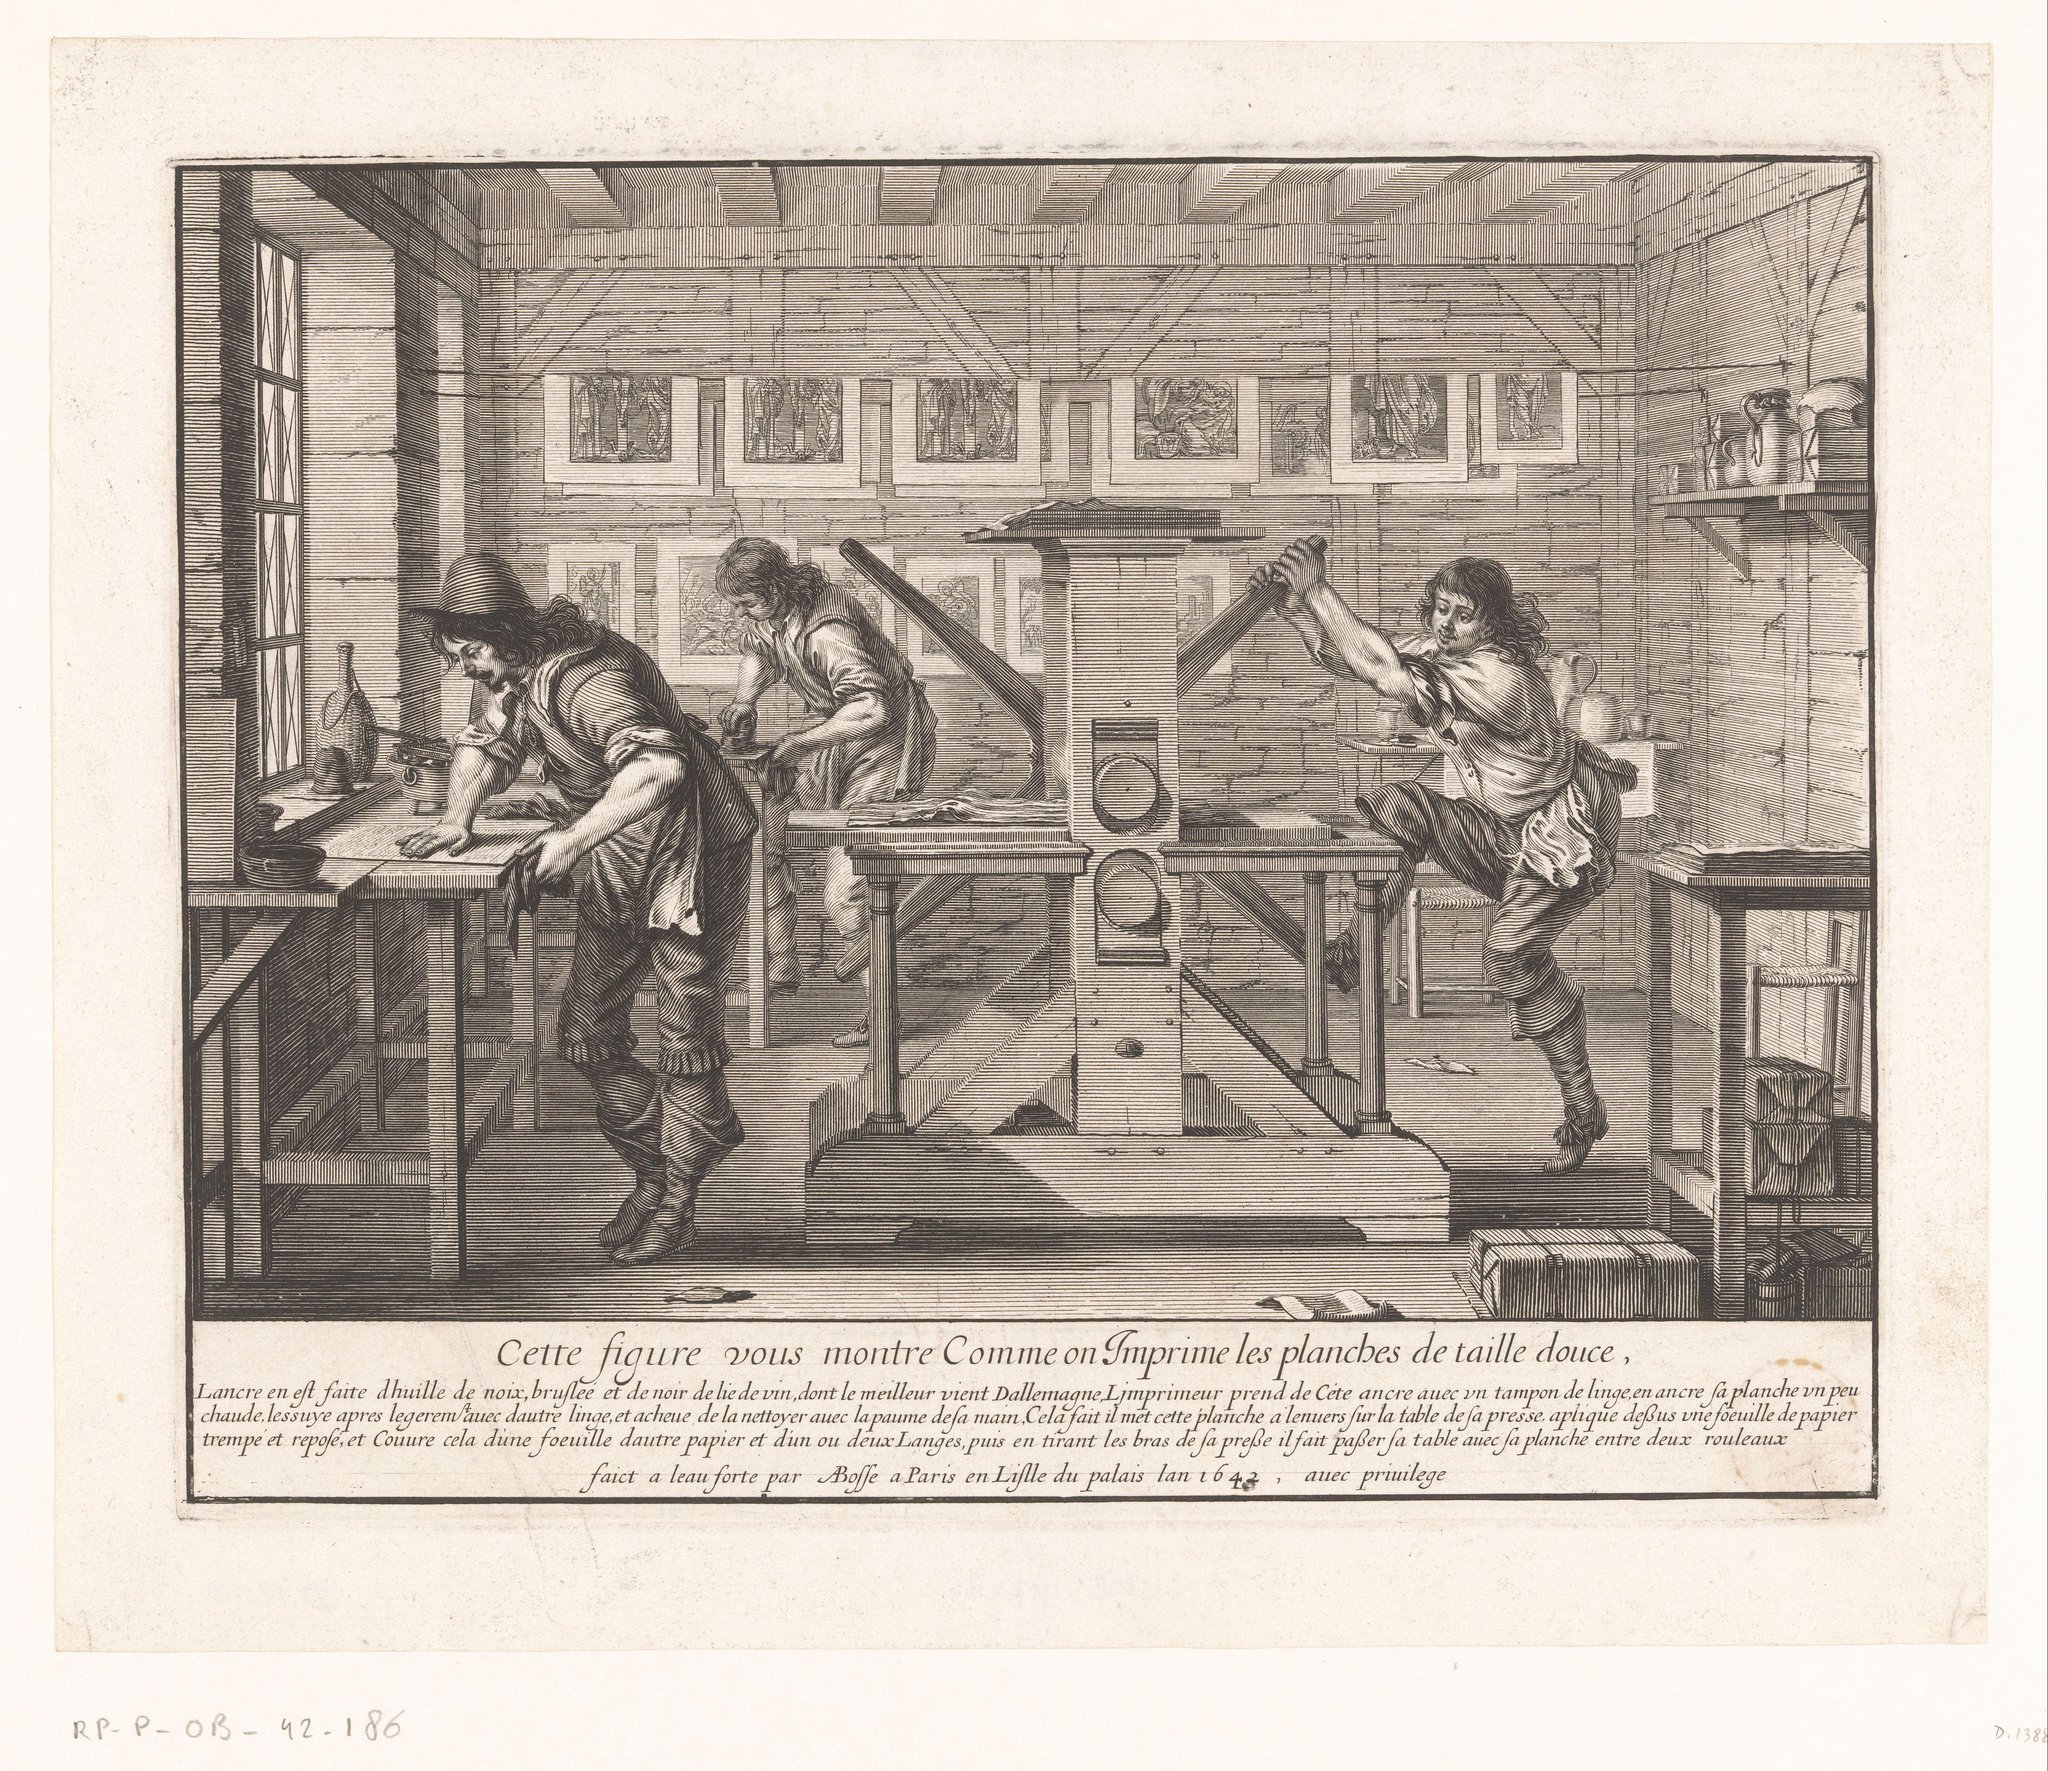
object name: print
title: Prentdrukkerij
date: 1642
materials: paper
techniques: etching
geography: paris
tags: printing press, printing, printing office, tools, implements of printer, persons ~ printing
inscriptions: collector's mark: Lugt 240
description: In de werkplaats wordt het drukken van etsen gedemonstreerd. De drukker op de achtergrond wrijft met een tampon de inkt op de plaat. De man voor de werkbank 'slaat de plaat af' met de palm van zijn hand. De schone plaat, waarop de inkt nu alleen nog in de fijne groeven zit, wordt afgedrukt op de etspers.